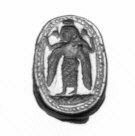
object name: stamp seal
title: Scarab seal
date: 600-501 BCE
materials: jasper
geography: levant or syria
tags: scarabs